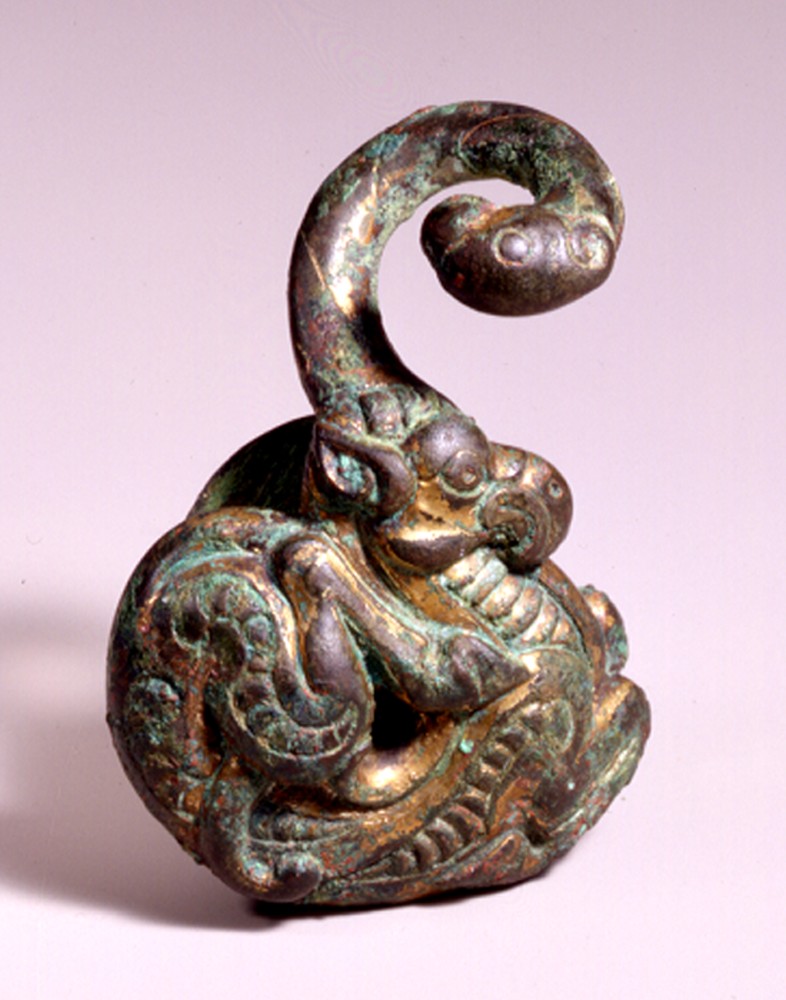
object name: garment hook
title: Hook with Raptor-Headed Ungulate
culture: north chinese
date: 300-101 BCE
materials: bronze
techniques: gilding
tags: mythical creatures